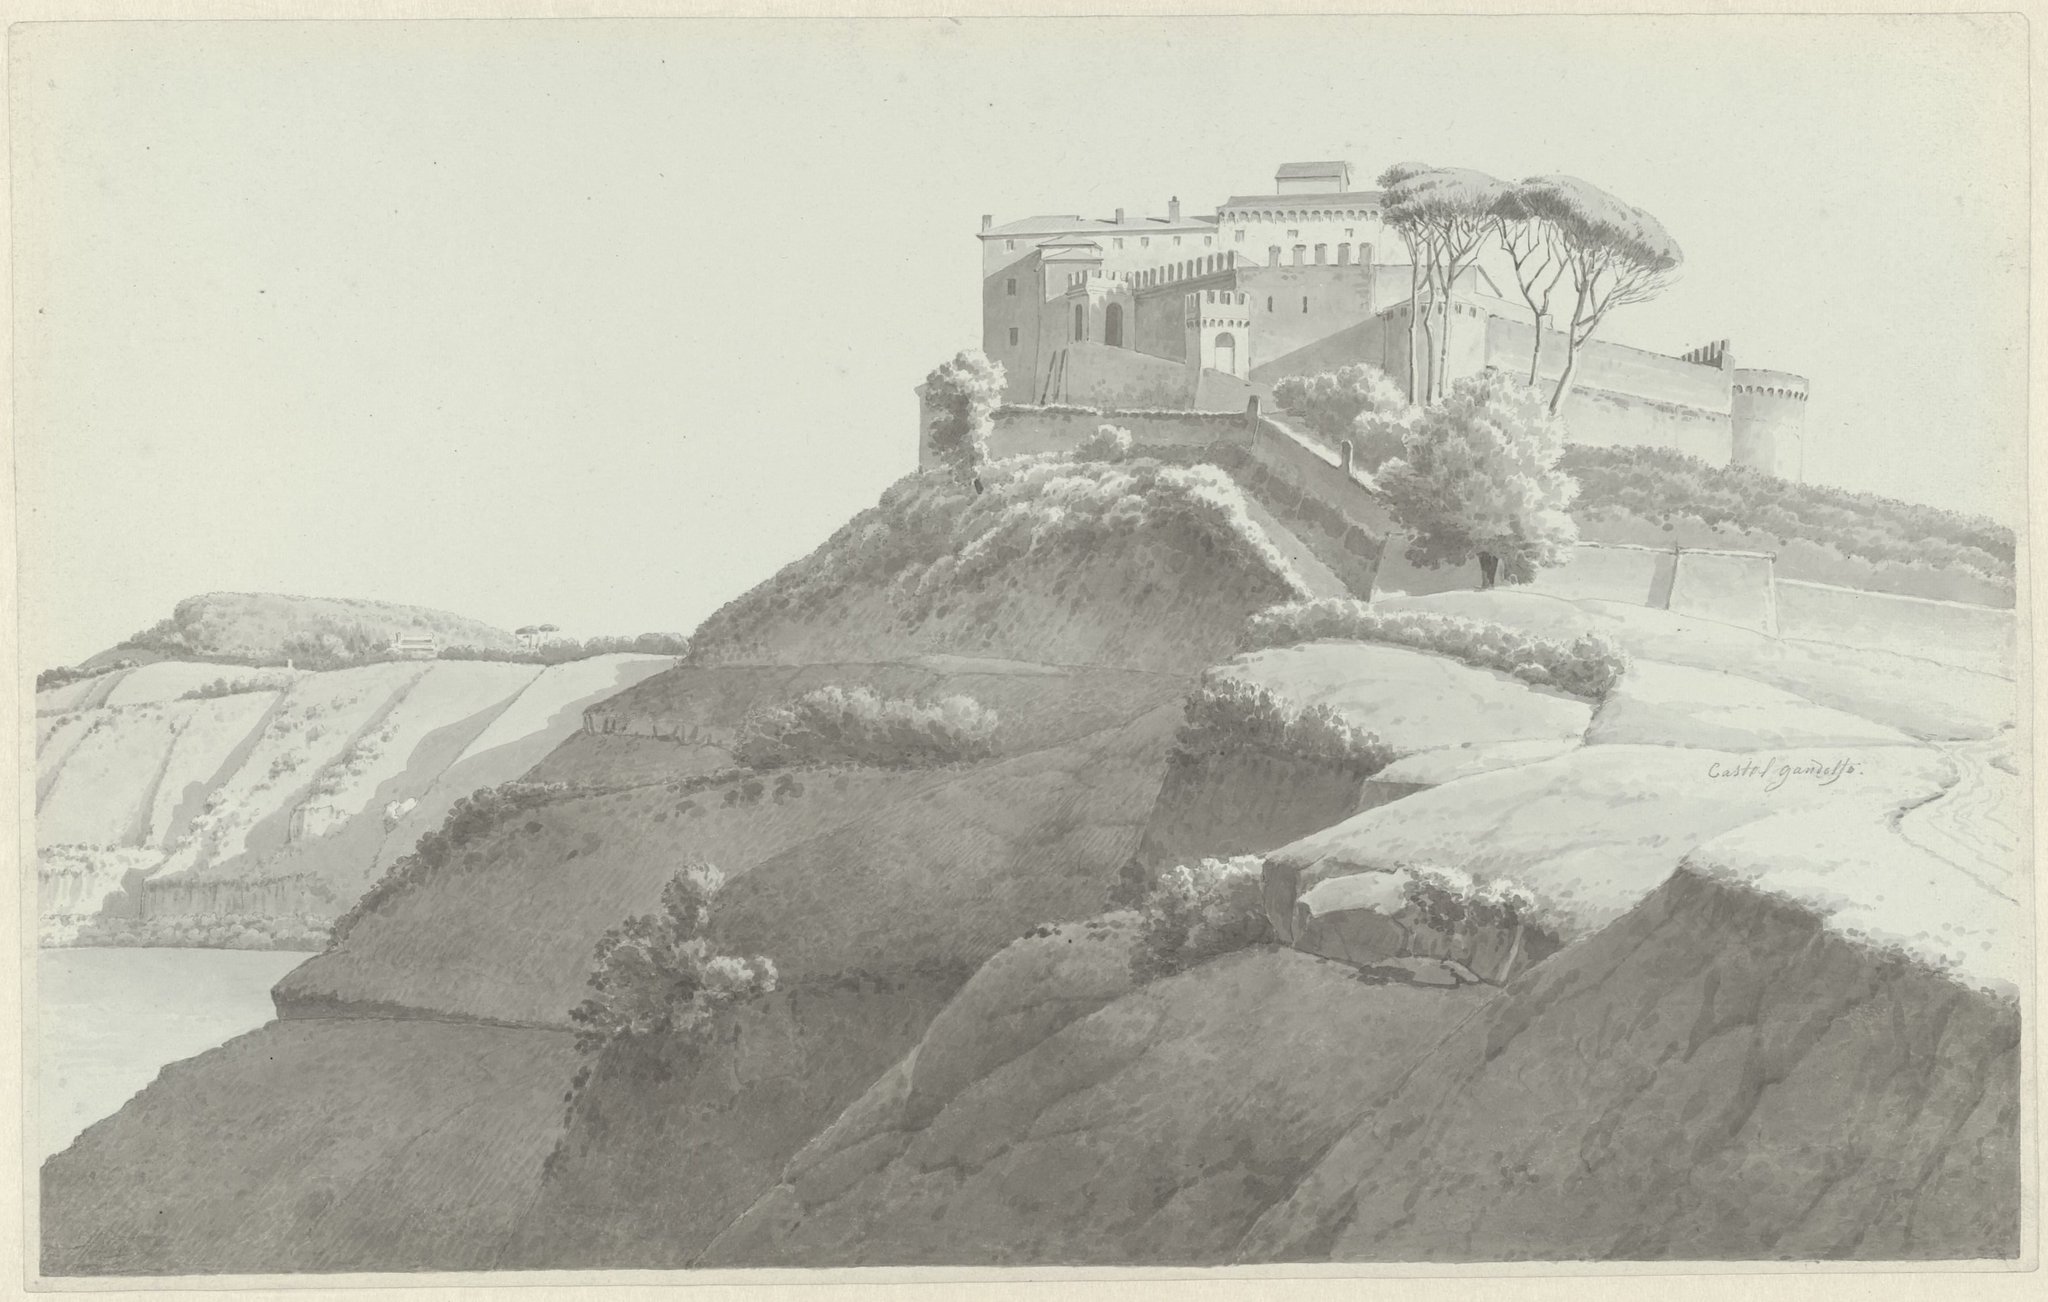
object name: drawing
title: Castel Gandolfo with Lake Albano at the Left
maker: josephus augustus knip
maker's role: draughtsman, painter, print maker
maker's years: 1777-1847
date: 1810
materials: graphite, paper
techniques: brush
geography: italy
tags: lake, villa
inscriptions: inscription: ‘Castel Gandolfo’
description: Rising up on the bank of Lake Albano, southeast of Rome, is the apostolic palace built in the 1620s, where the pope traditionally resides for part of the summer and early autumn. Pope Francis plans to turn the palace into a museum and open it up to the public.